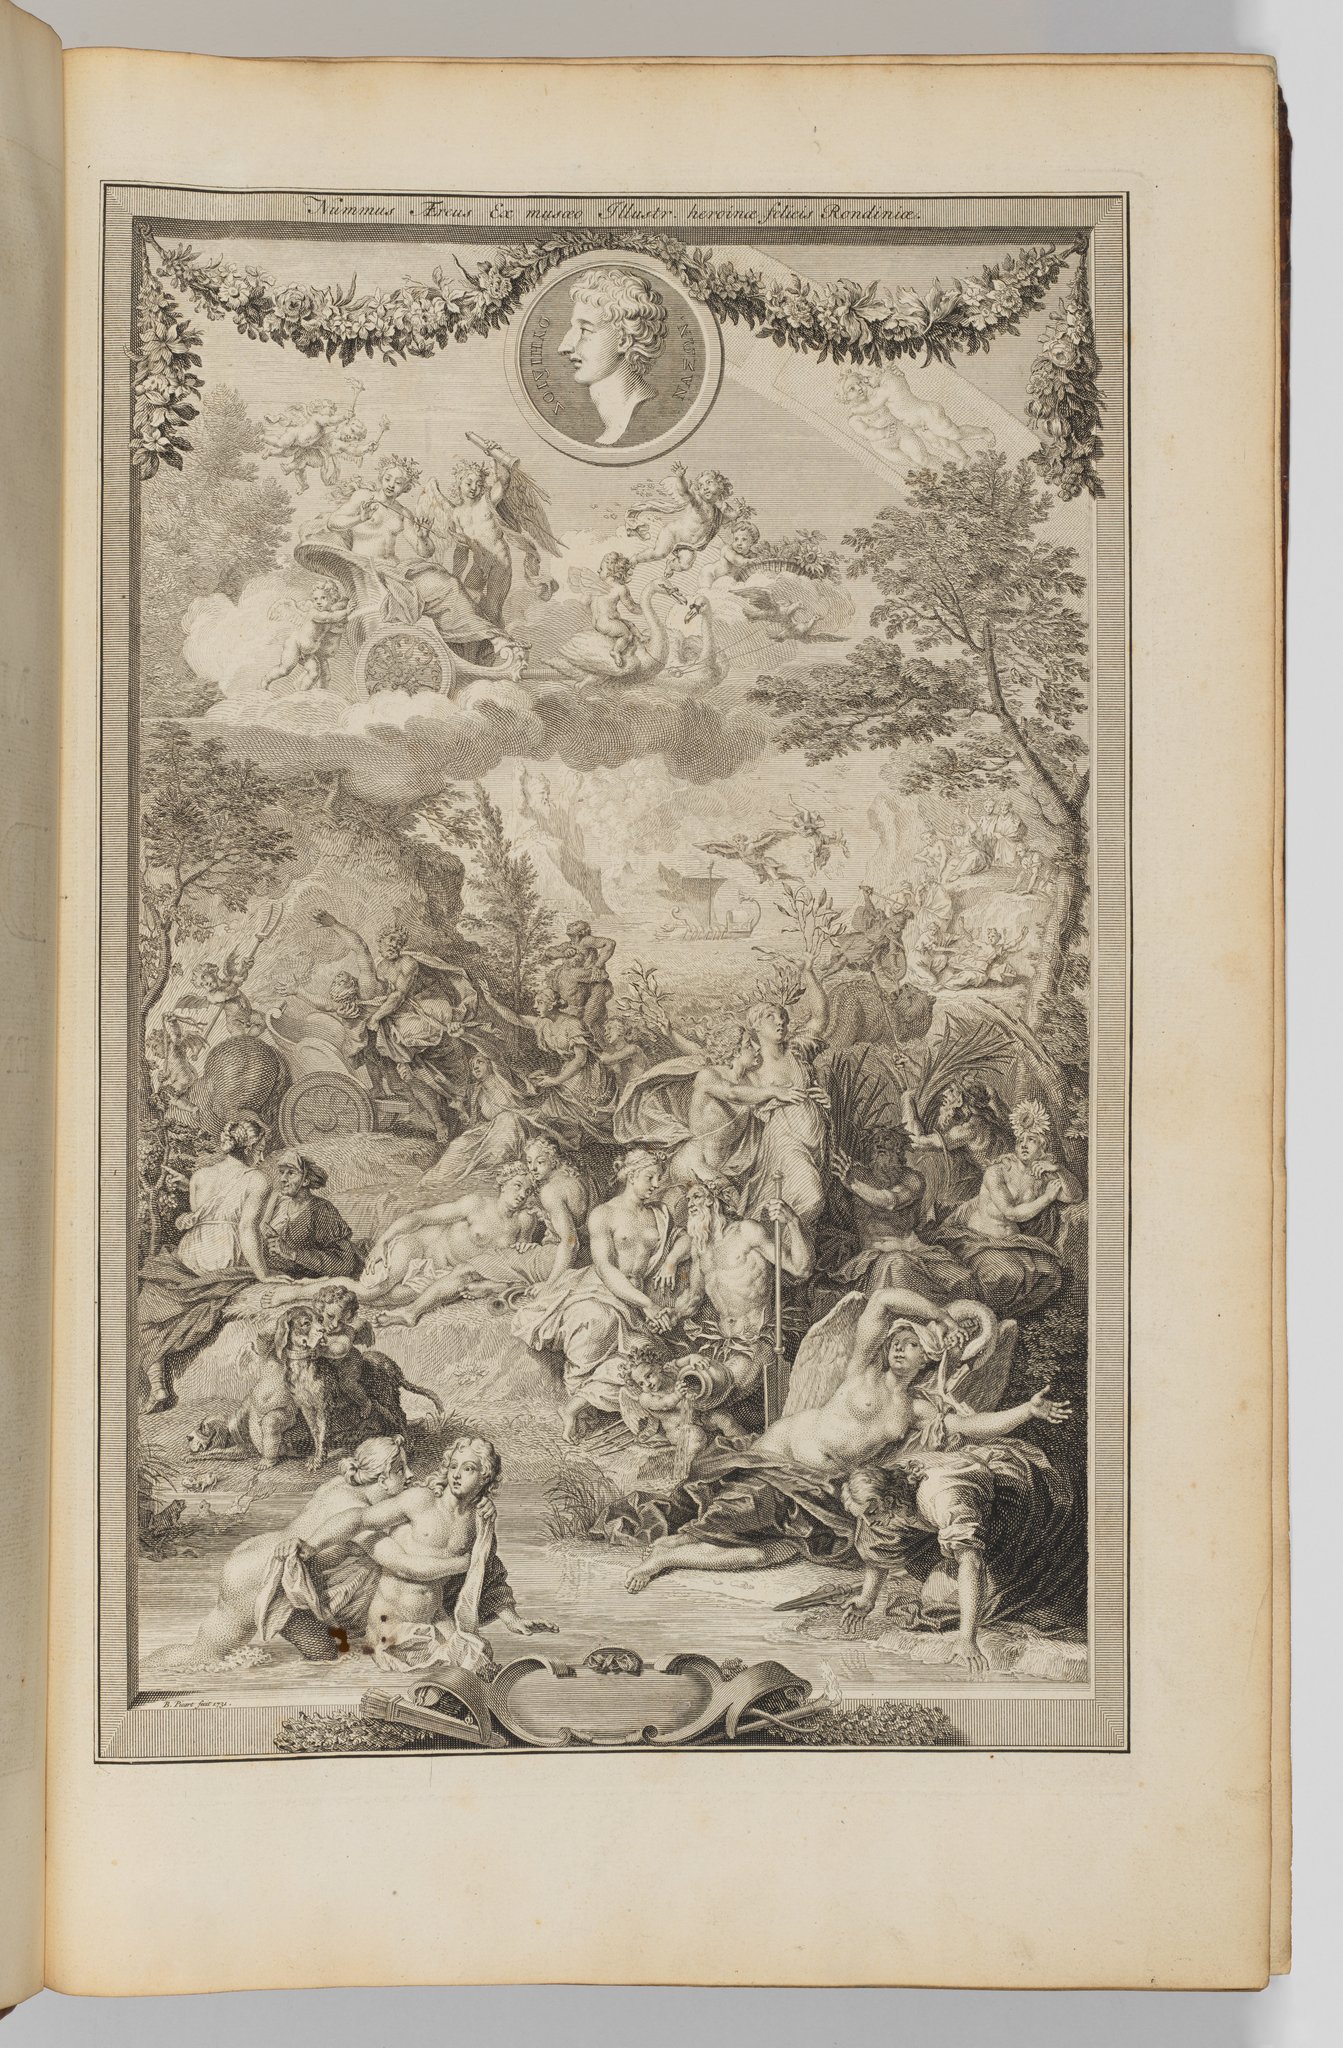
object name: book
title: Les Métamorphoses d'Ovide, Vol. I and II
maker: ovid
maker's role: author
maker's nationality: roman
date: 1732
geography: amsterdam